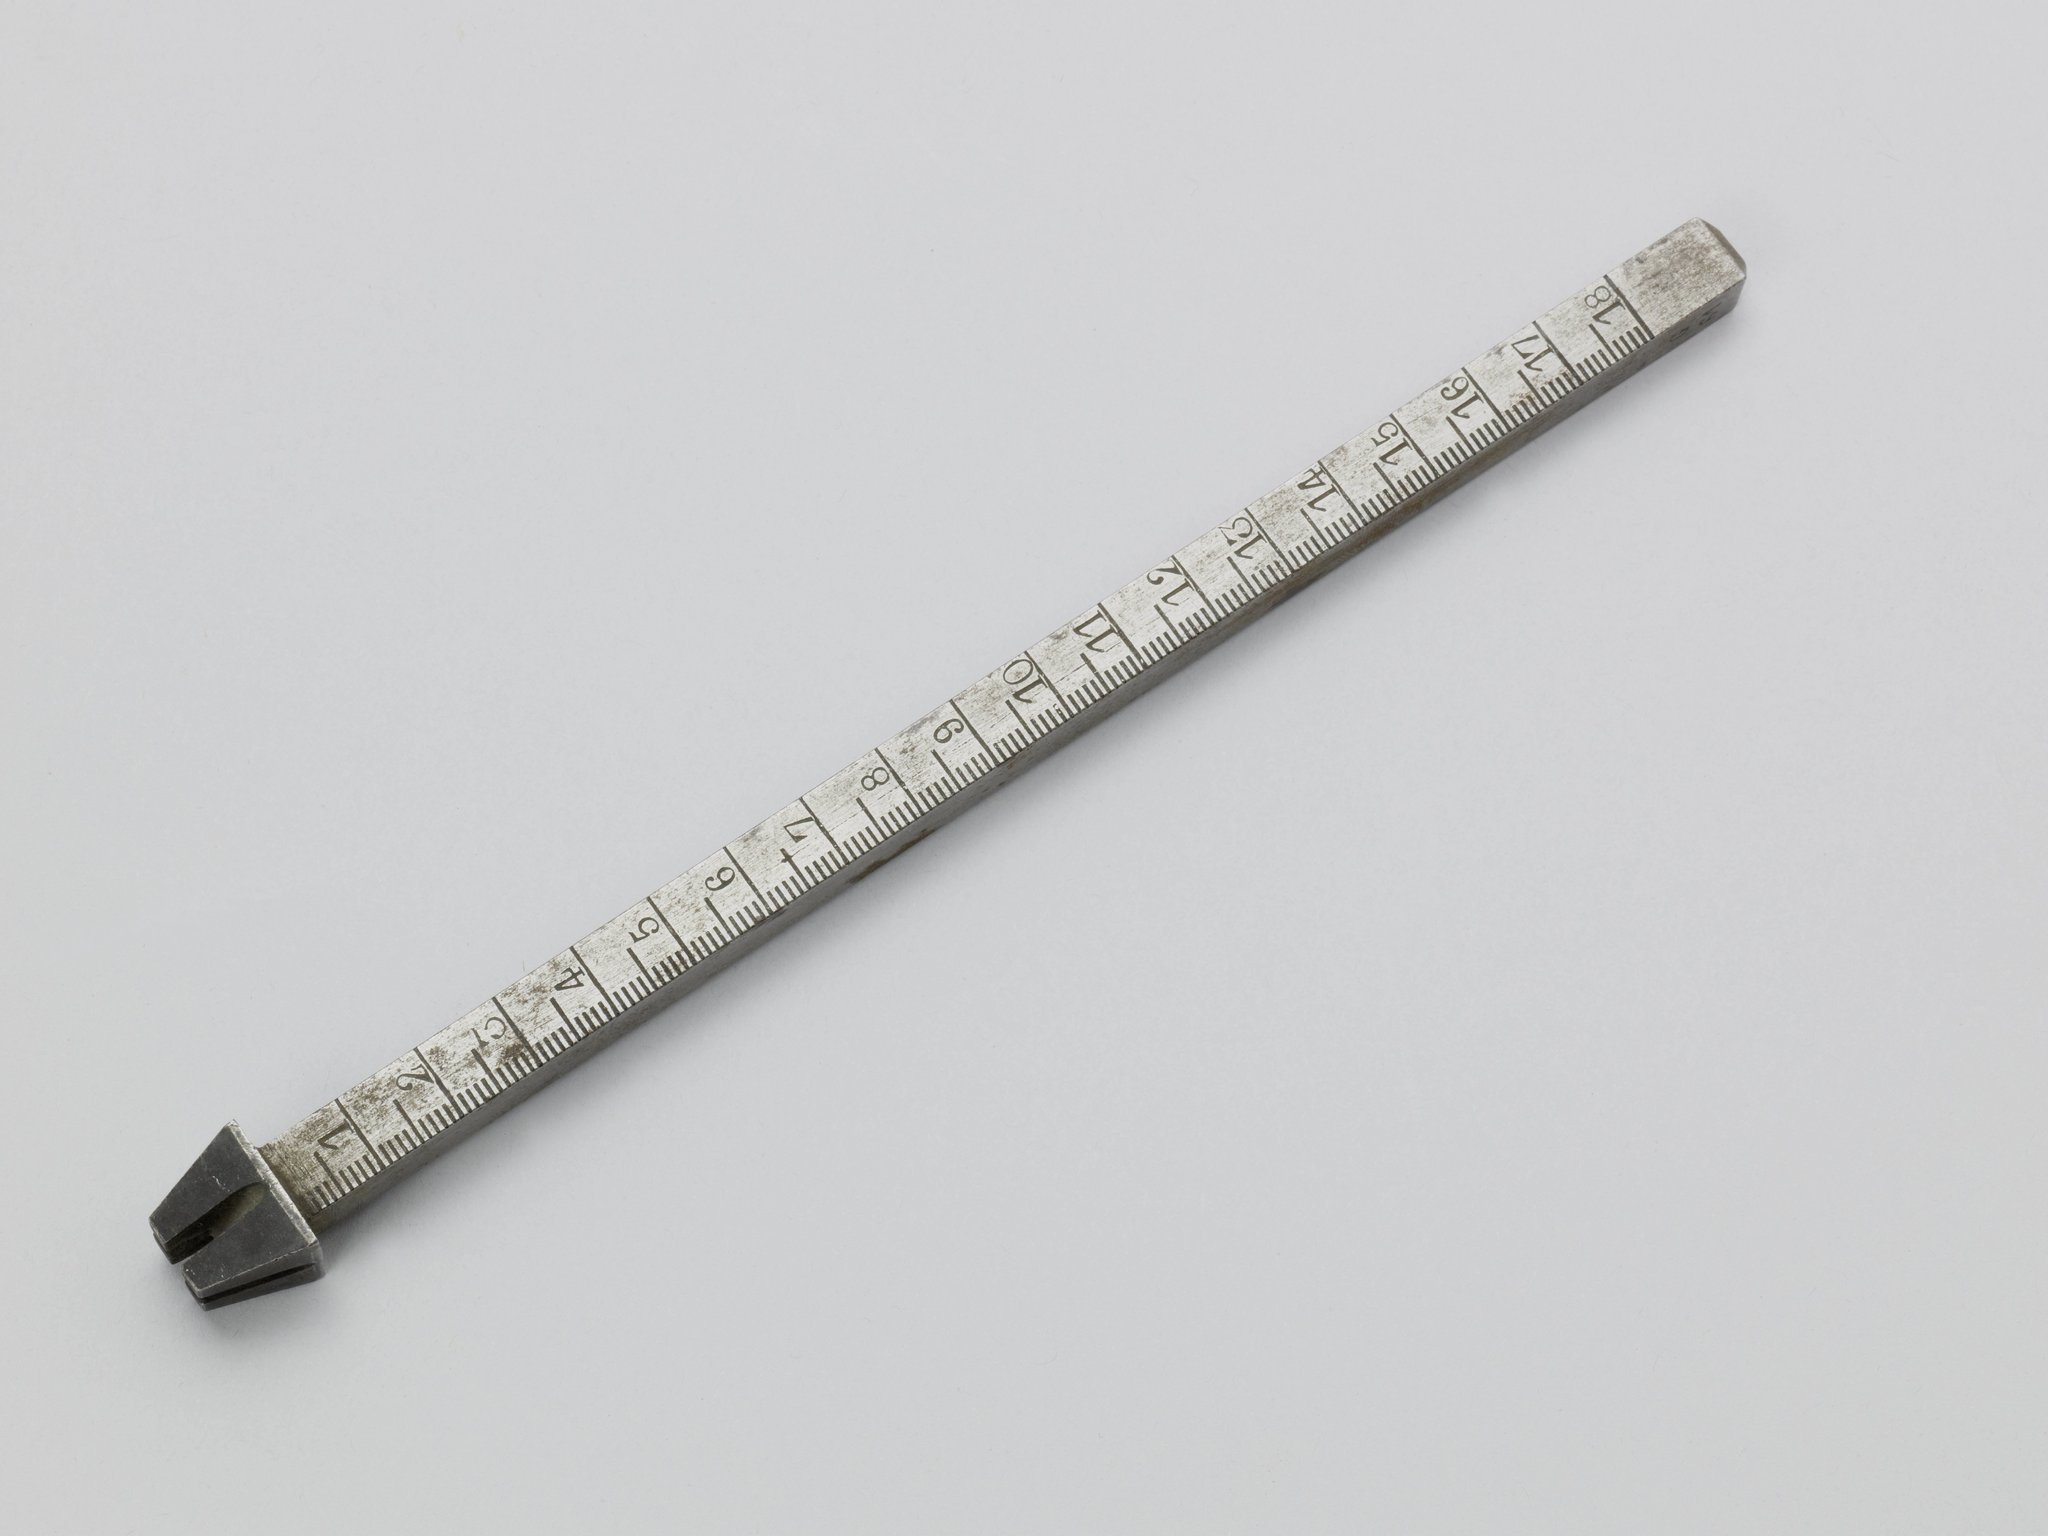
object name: test model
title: Tangent Sight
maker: Anonymous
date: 1860-1870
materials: iron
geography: netherlands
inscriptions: inscription: ‘G / 61’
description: Een korte opzetstang, bestaande uit een vierkante ijzeren staaf met pyramidevormige top waar groeven dwars over lopen. Aan een zijde is een schaal aangebracht, gaande van 0 tot 18: de afstand tussen de nummers is precies 1 cm. Deze en NG-MC-1889-29-A passen beide in steun NG-MC-1374.